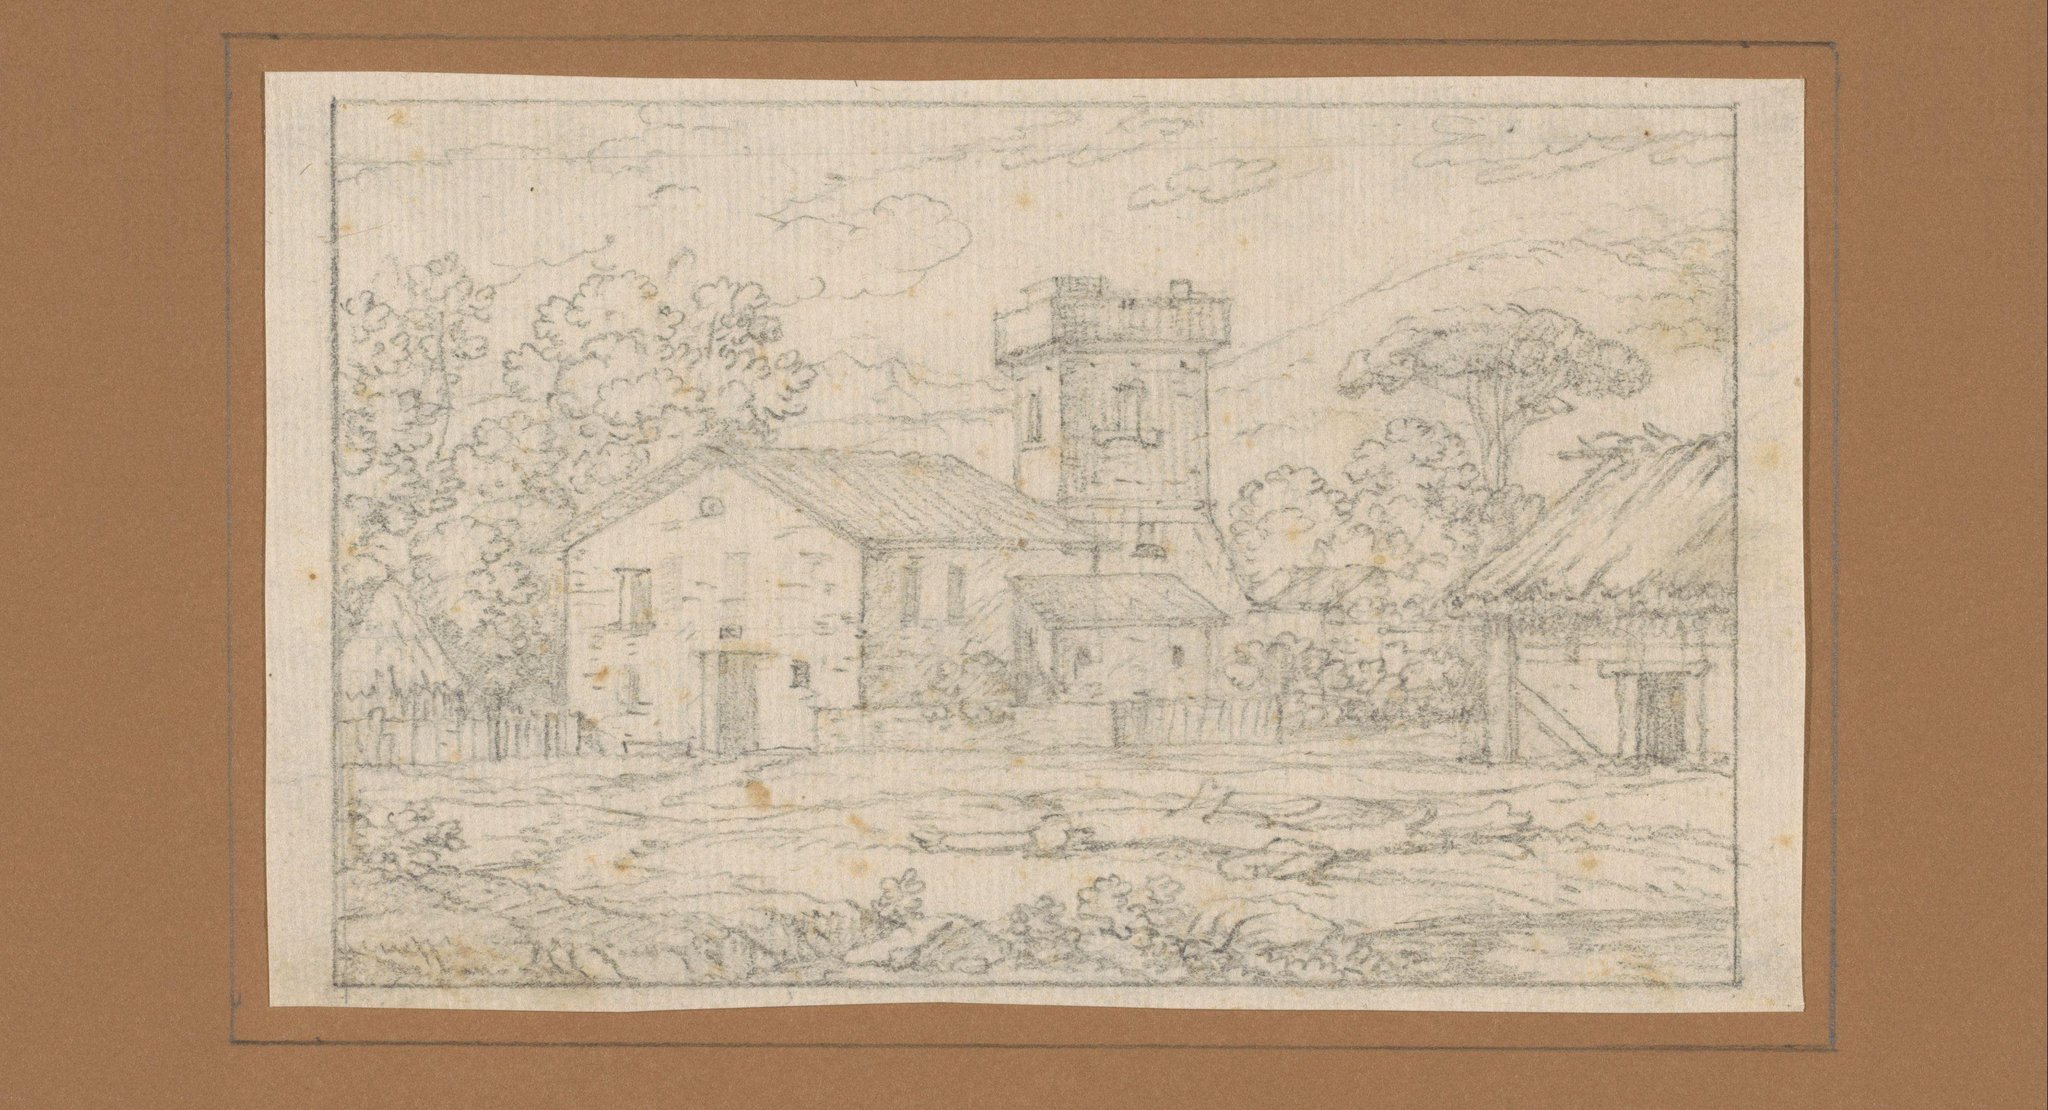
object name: drawing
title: Landhuis met toren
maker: christoph heinrich kniep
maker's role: draughtsman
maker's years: 1755-1825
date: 1765-1825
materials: paper, pencil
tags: rural housing, e.g. country-house, villa, cottage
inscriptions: collector's mark: Lugt 2228